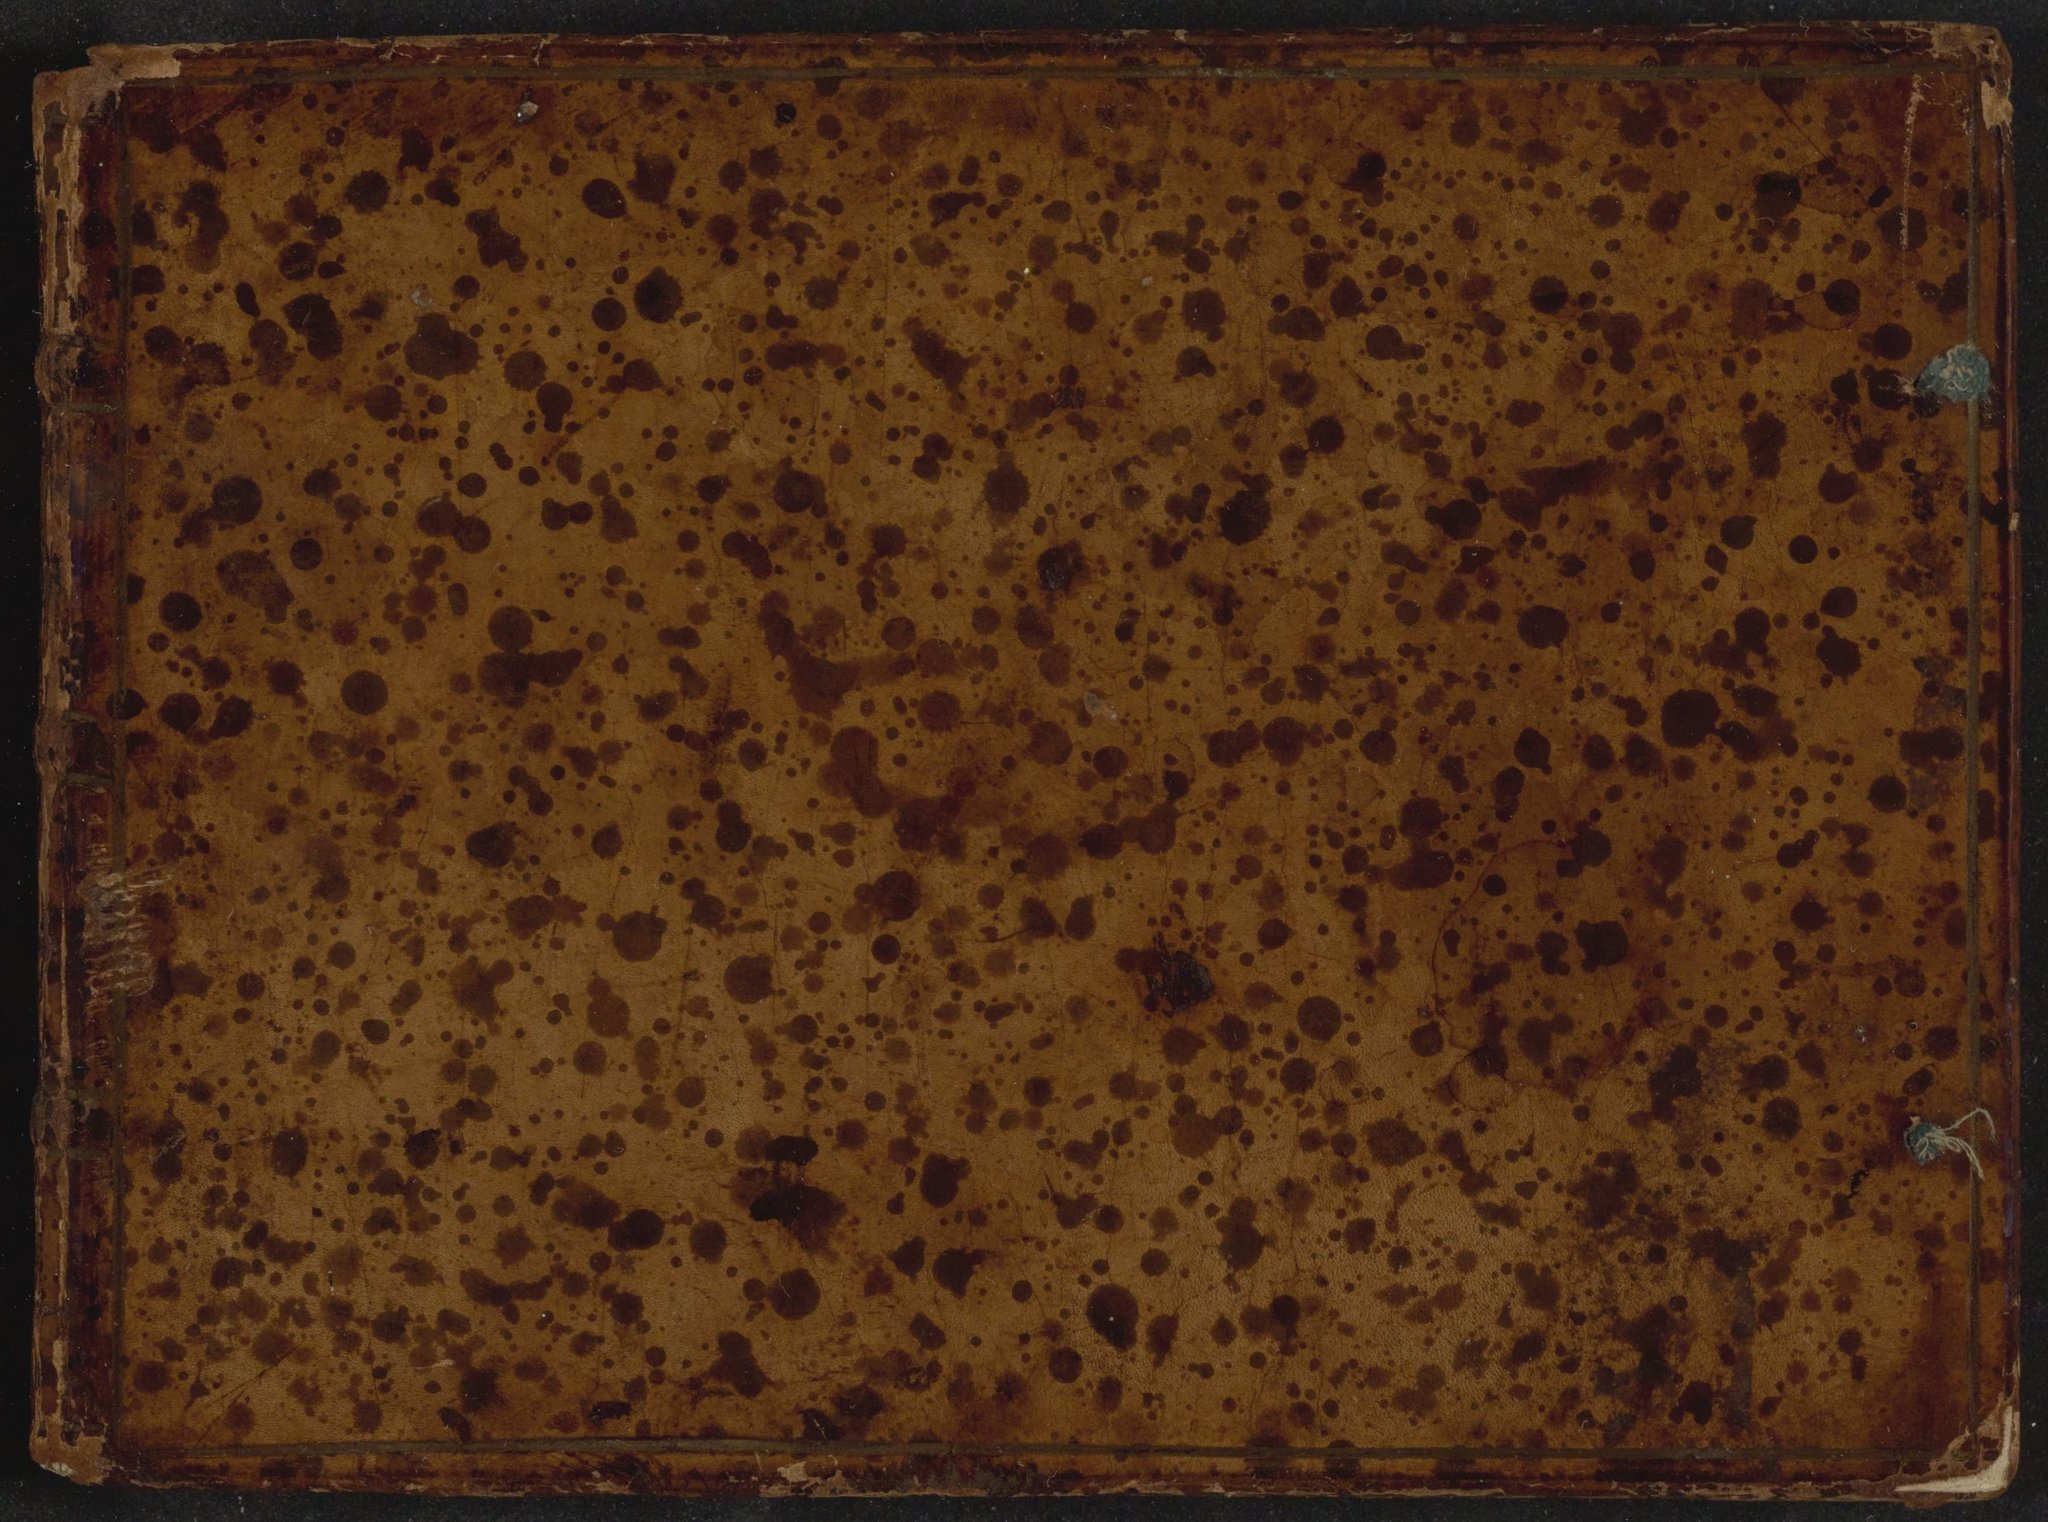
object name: prentrecueil, prentenalbum, prentalbum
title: Album met prenten over de natuurlijke historie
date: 1635-1660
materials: leather, paper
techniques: bookbinding, engraving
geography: low countries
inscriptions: inscription: ‘BK’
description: Album met 52 prenten op 50 albumbladen in een kalfsleren band van oblong formaat. Het album bevat verschillende prentseries met als onderwerp 'natuur' in de breedste zin van het woord. Het album bevat twee series over de vier seizoenen, een serie over de vijf zintuigen, een serie goden en godinnen van prentmaker Crispijn van de Passe (I), de serie Bestiarium quadrupedum Vivae Icones over landdieren, de serie Avium Vivae Icones over vogels, de serie Piscium Vivae Icones over vissen en tot slot de serie bloemen. Het album is mogelijk samengesteld in Antwerpen. Voorin drie blanco bladen, achterin zes blanco bladen. Op de schutbladen vermoedelijk lijmresten van fotohoekjes. Op een van de bladen achterin is een paard getekend.